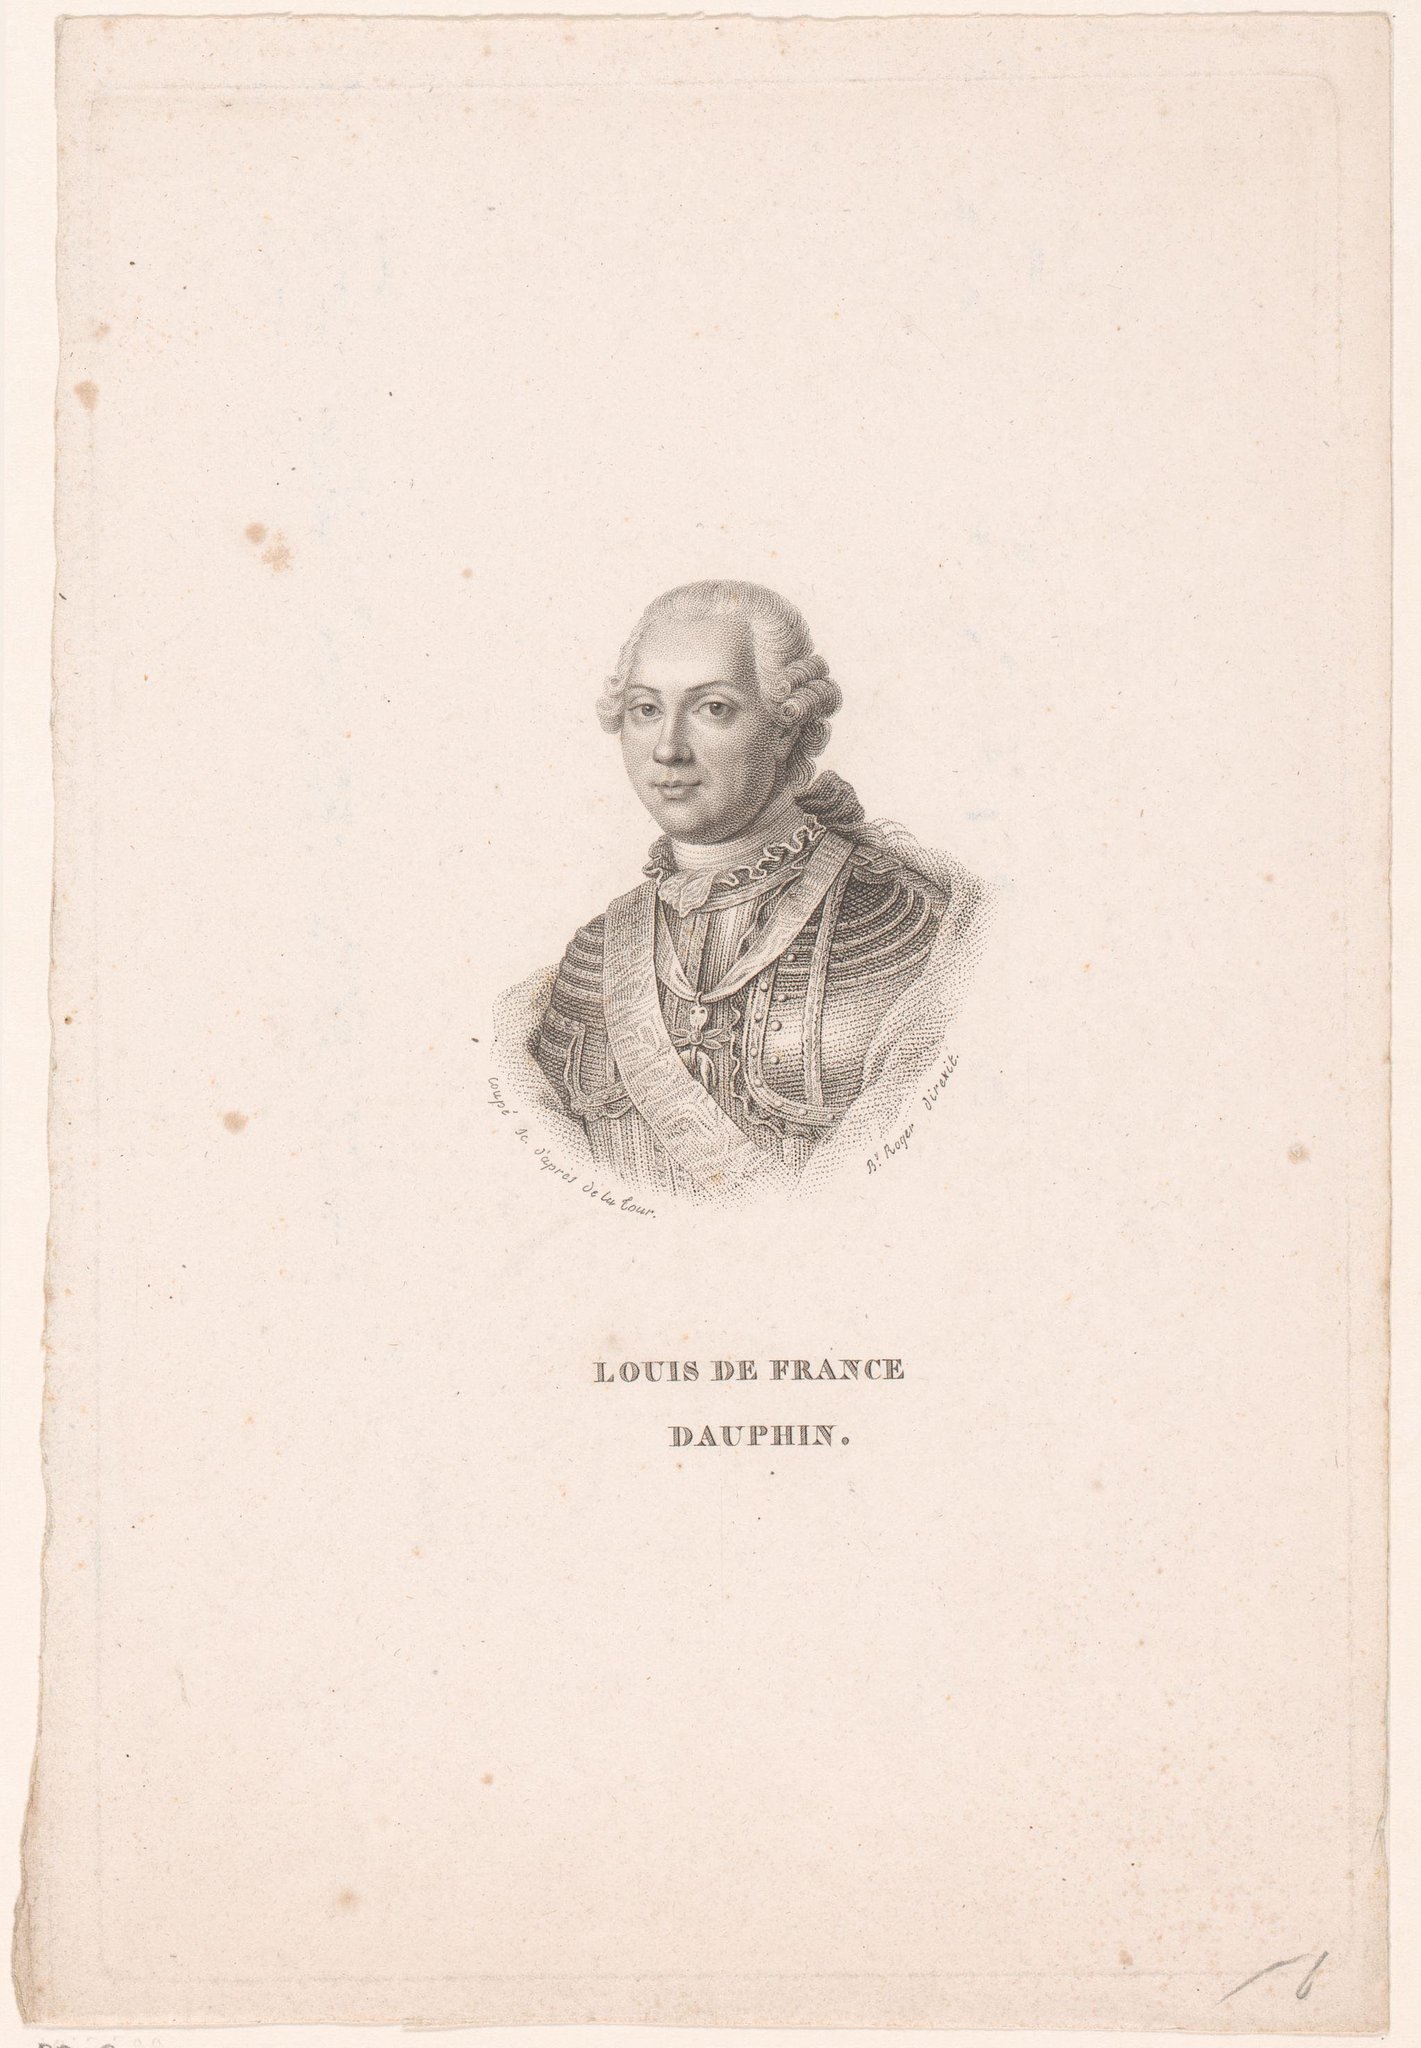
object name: print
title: Portret van Lodewijk van Frankrijk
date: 1794-1846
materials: paper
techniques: engraving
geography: france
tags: lodewijk van frankrijk (dauphin van frankrijk), historical persons, king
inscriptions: collector's mark: Lugt 2228